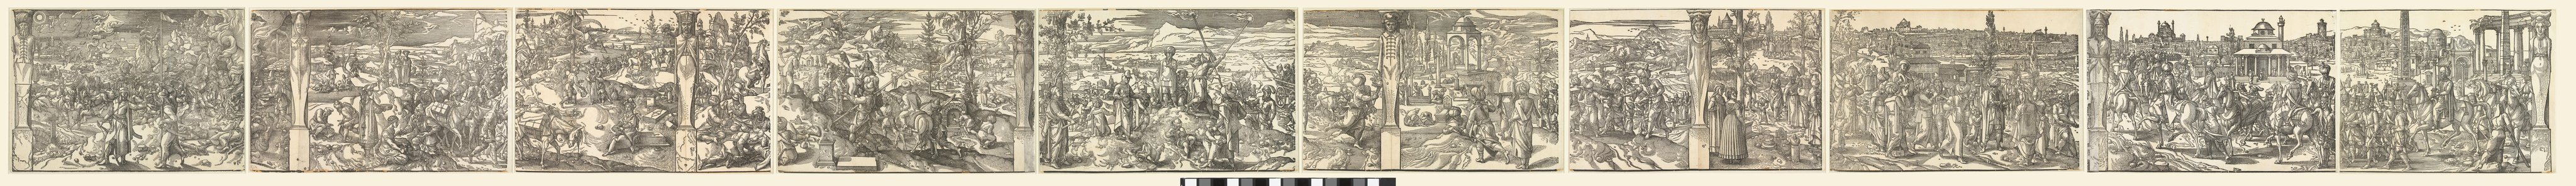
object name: print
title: Zeden en Gewoonten der Turken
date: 1553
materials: paper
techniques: woodcut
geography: low countries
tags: asiatic races and peoples: turks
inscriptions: collector's mark: Lugt 240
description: Dit object is omwille van een betere presentatie virtueel samengevoegd, maar bestaat fysiek uit losse onderdelen.